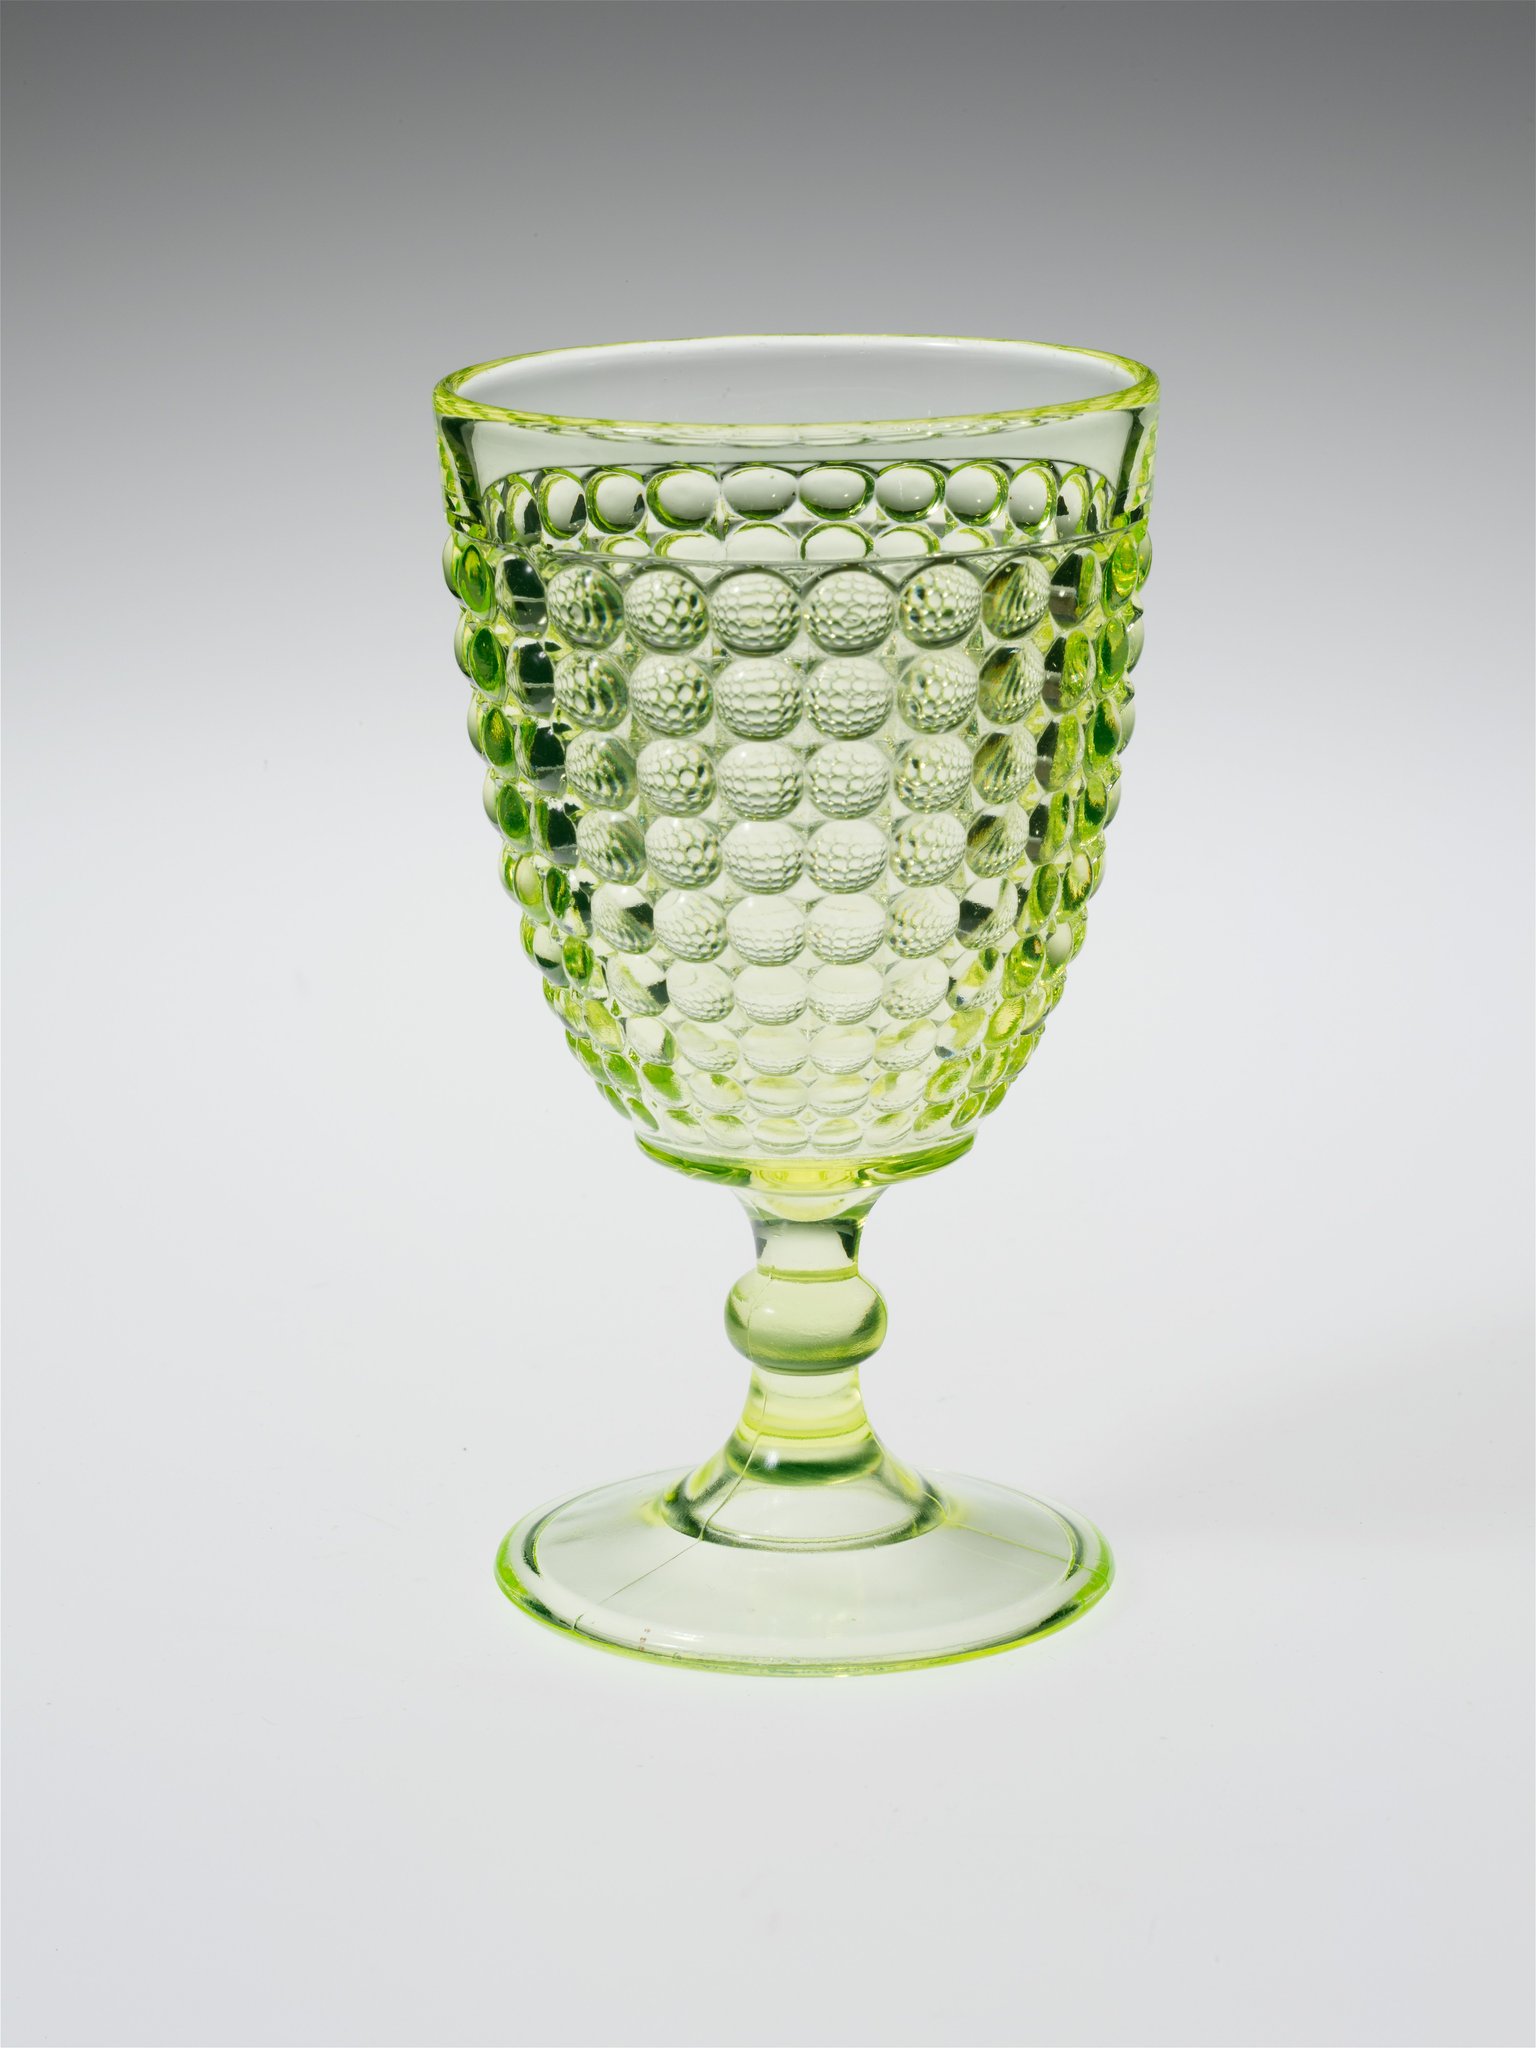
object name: goblet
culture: american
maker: adams and company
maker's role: maker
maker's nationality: american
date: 1880-1890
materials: glass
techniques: pressed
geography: united states